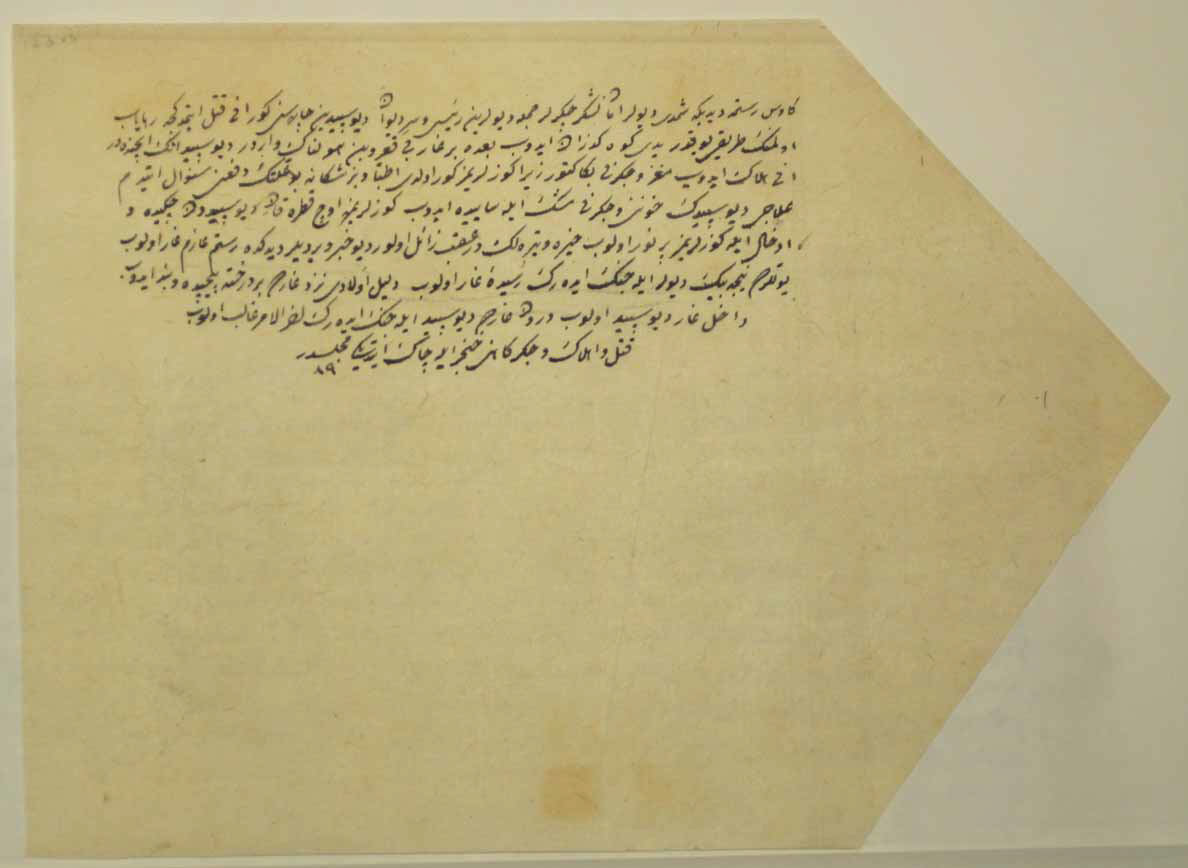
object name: illustrated manuscript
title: Page of Calligraphy from the Shahnama (Book of Kings) of Shah Tahmasp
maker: abu'l qasim firdausi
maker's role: author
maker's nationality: iranian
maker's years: 935-1020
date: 1501-1600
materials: ink, paper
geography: iran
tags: poetry